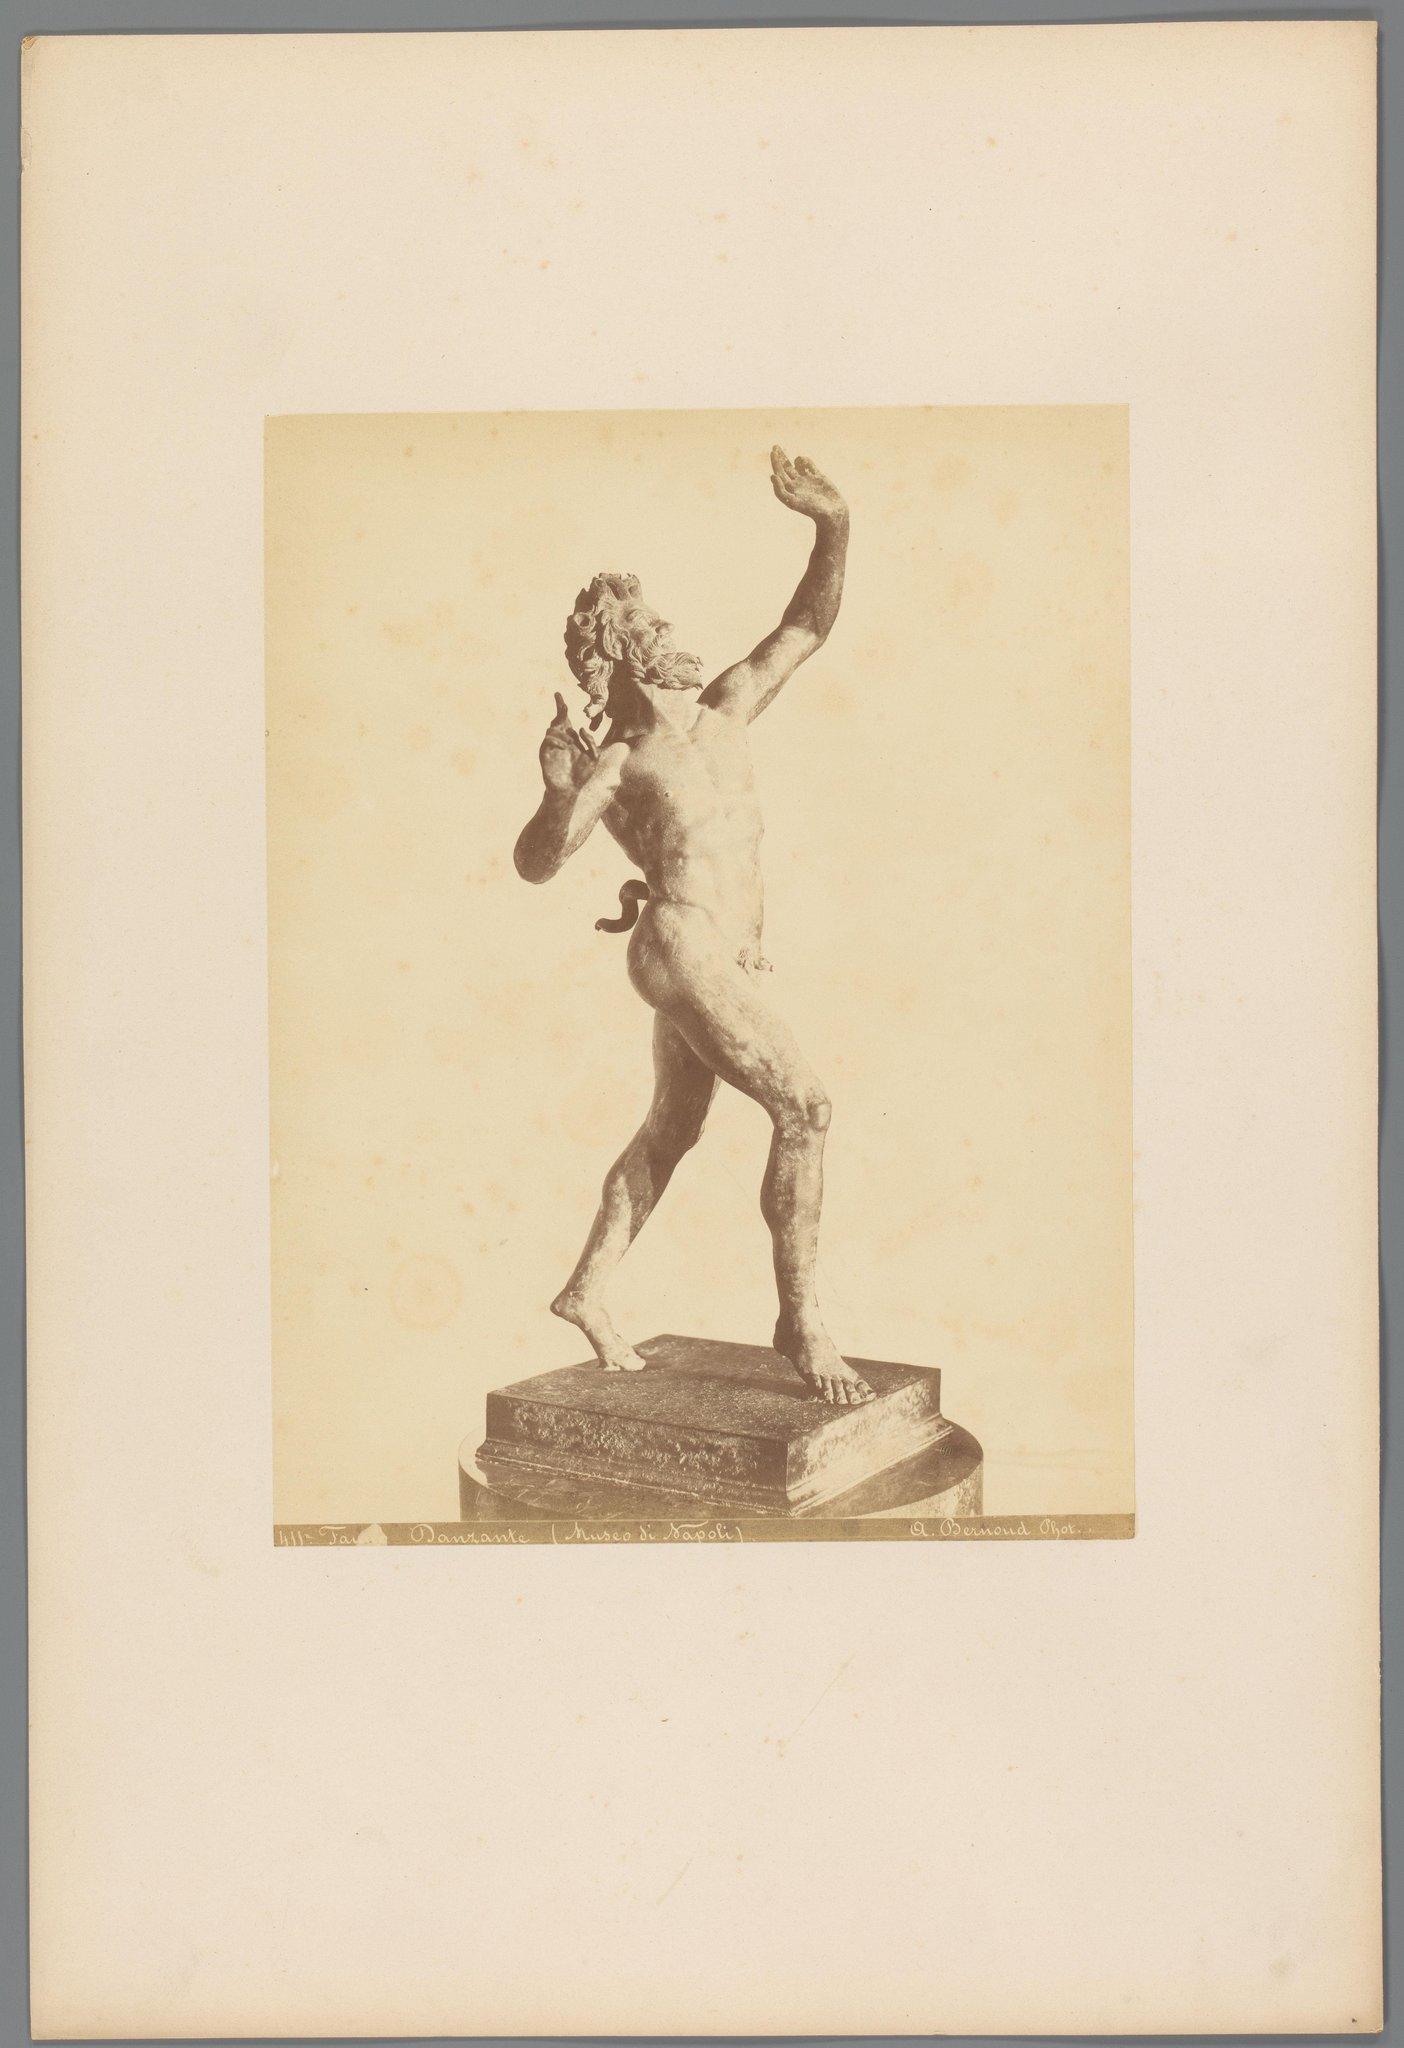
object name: photograph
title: (Museo di Napoli)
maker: alphonse bernoud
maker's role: fotograaf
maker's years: 1820-1889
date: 1851-1873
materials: cardboard, paper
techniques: albumen print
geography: naples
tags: satyrs, fauns, sileni, piece of sculpture, reproduction of a piece of sculpture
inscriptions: number: ‘411’